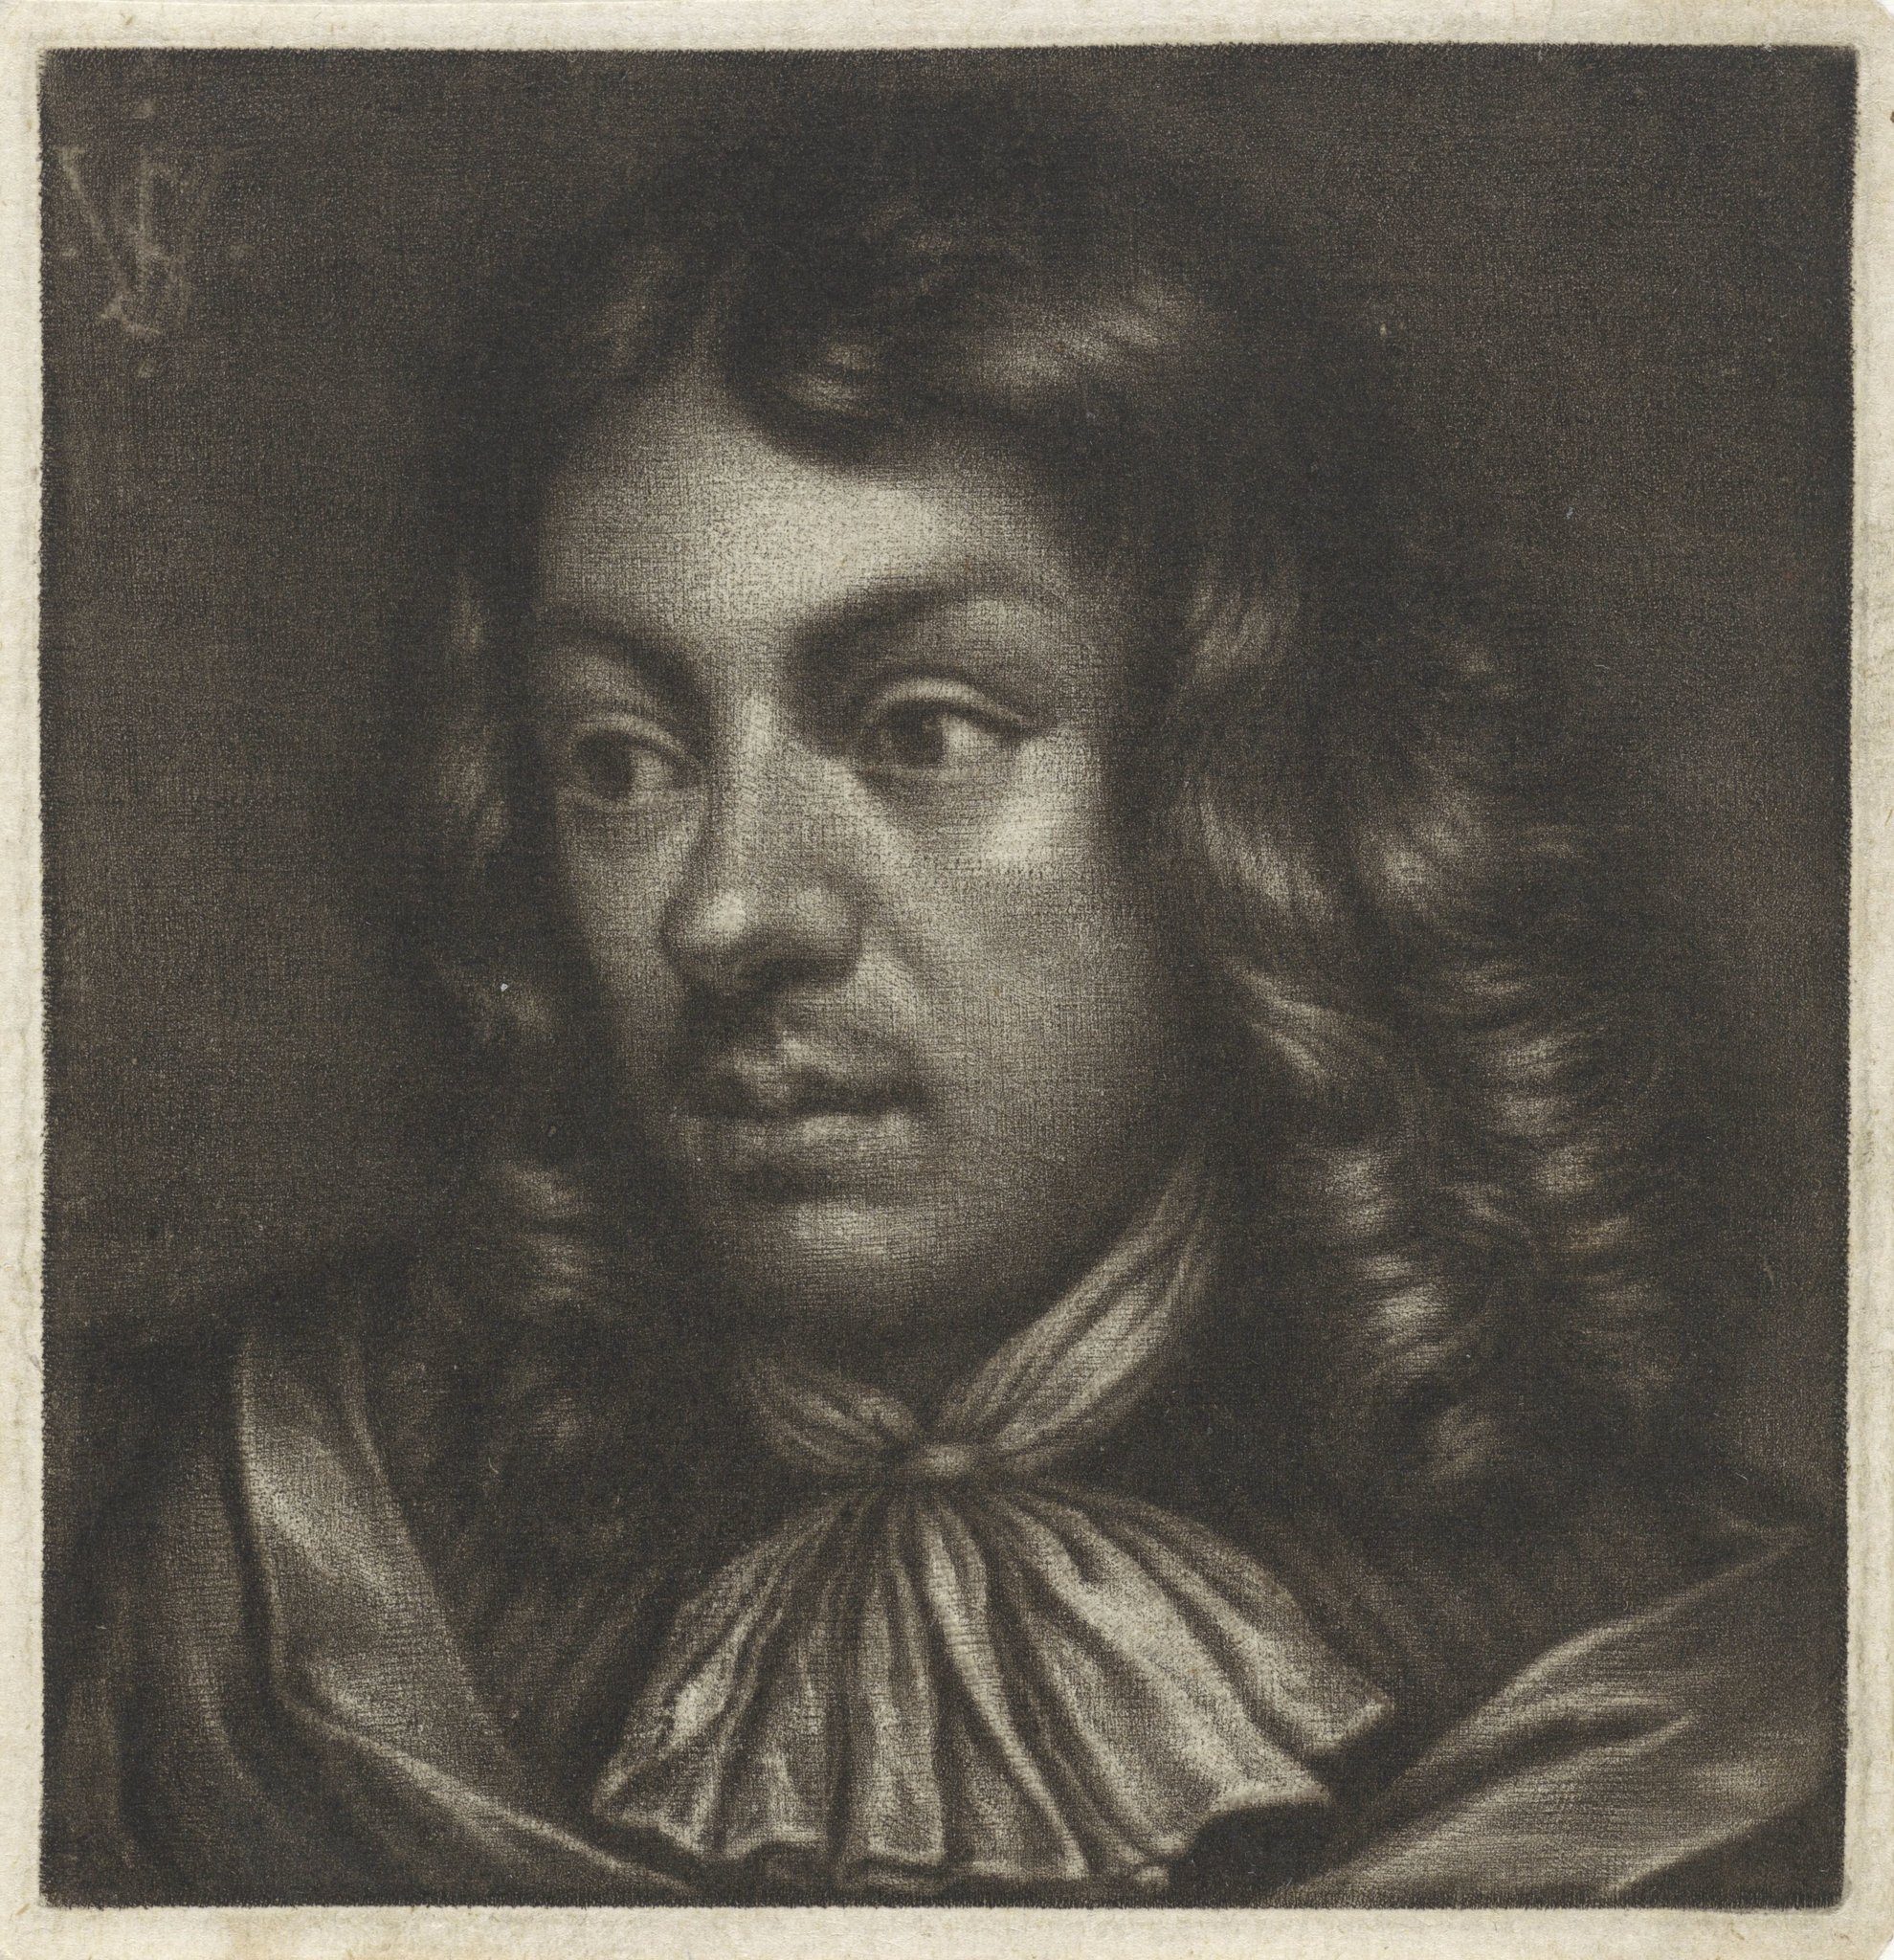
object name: print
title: Portret van een jonge man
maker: jan van somer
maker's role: draughtsman, print maker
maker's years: 1645-1699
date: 1655-1700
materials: paper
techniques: mezzotint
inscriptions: collector's mark: Lugt 2228